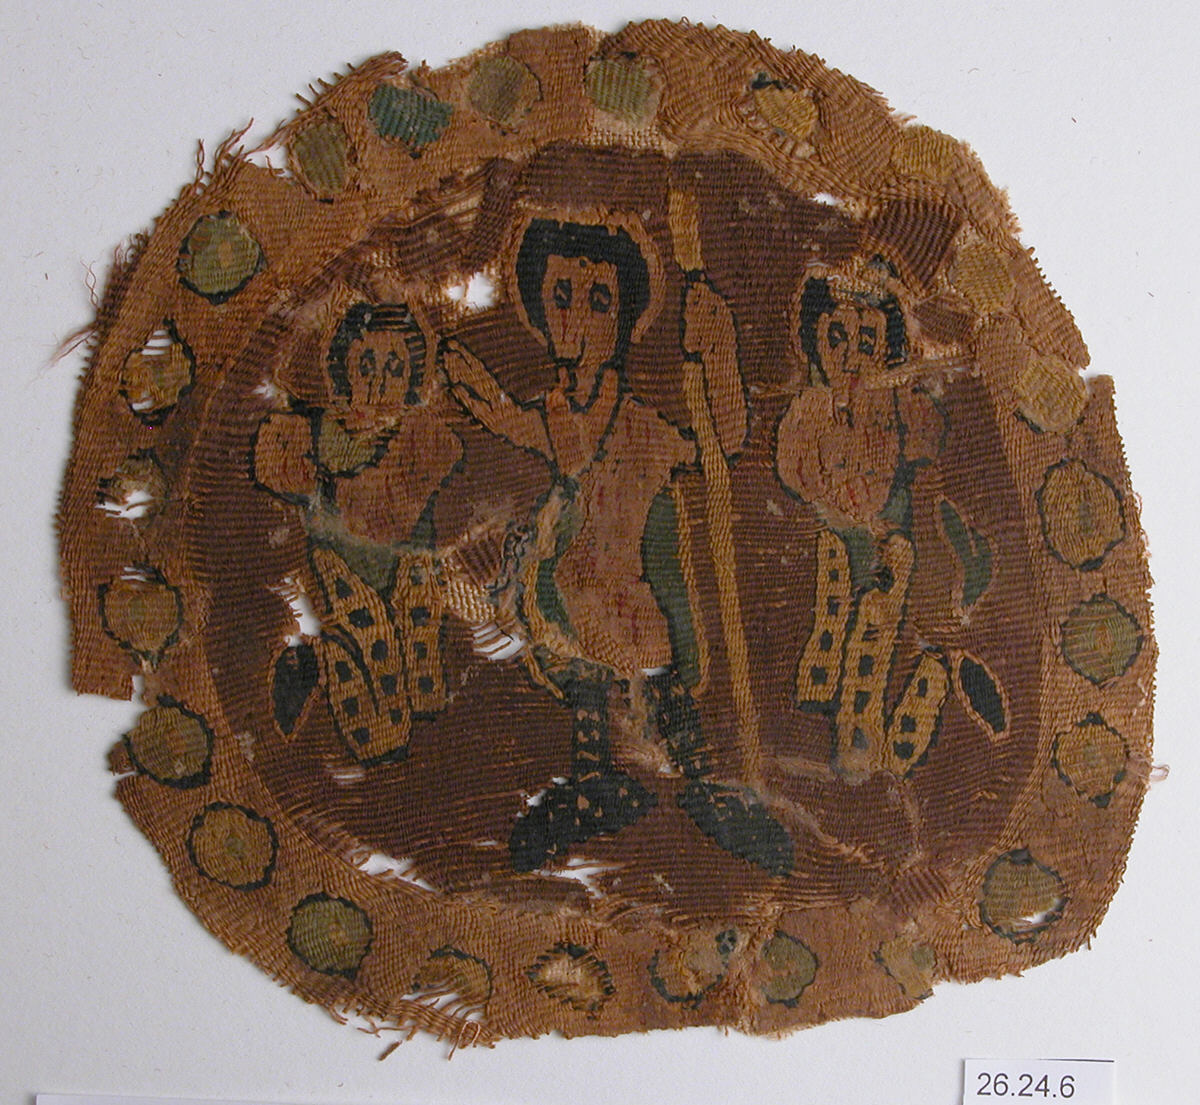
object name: roundel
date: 401-600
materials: linen, wool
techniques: weave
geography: egypt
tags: human figures